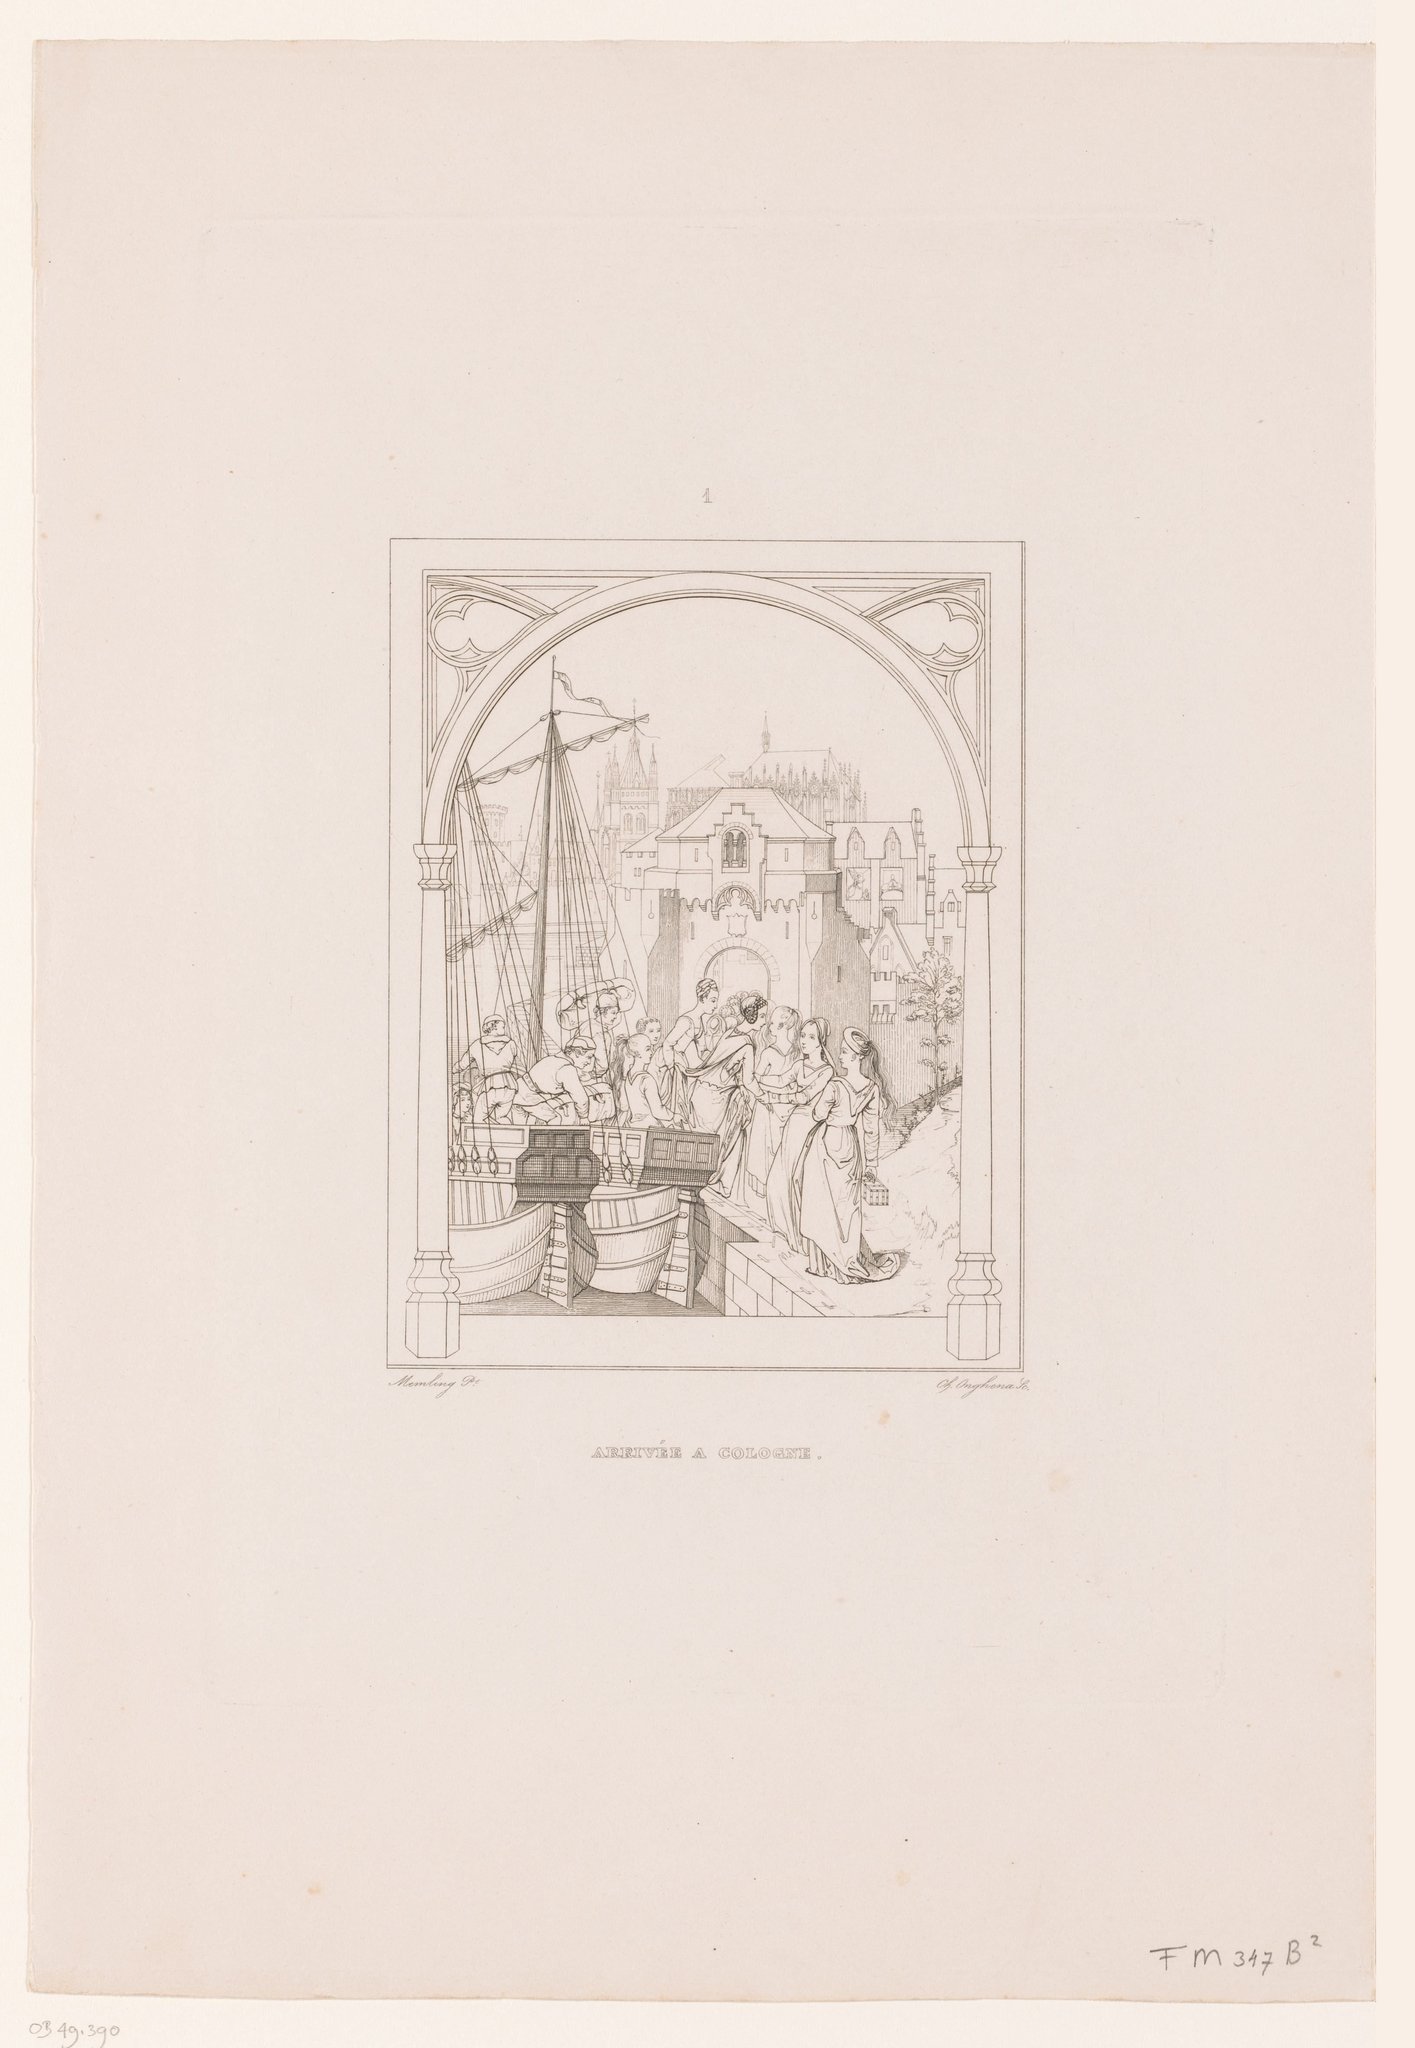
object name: print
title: Arrivée a Cologne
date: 1841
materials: paper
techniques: etching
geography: brussels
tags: the virgin martyr ursula of cologne; possible attributes: arrow, banner with red cross, cloak of ermine, crown, ship, relics (and reliquaries)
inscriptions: collector's mark: Lugt 2228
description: Prent uit: Delepierre, Octave en Auguste Voisin. La Châsse de St. Ursule. Brussel: Société des Beaux-Arts, [1841].